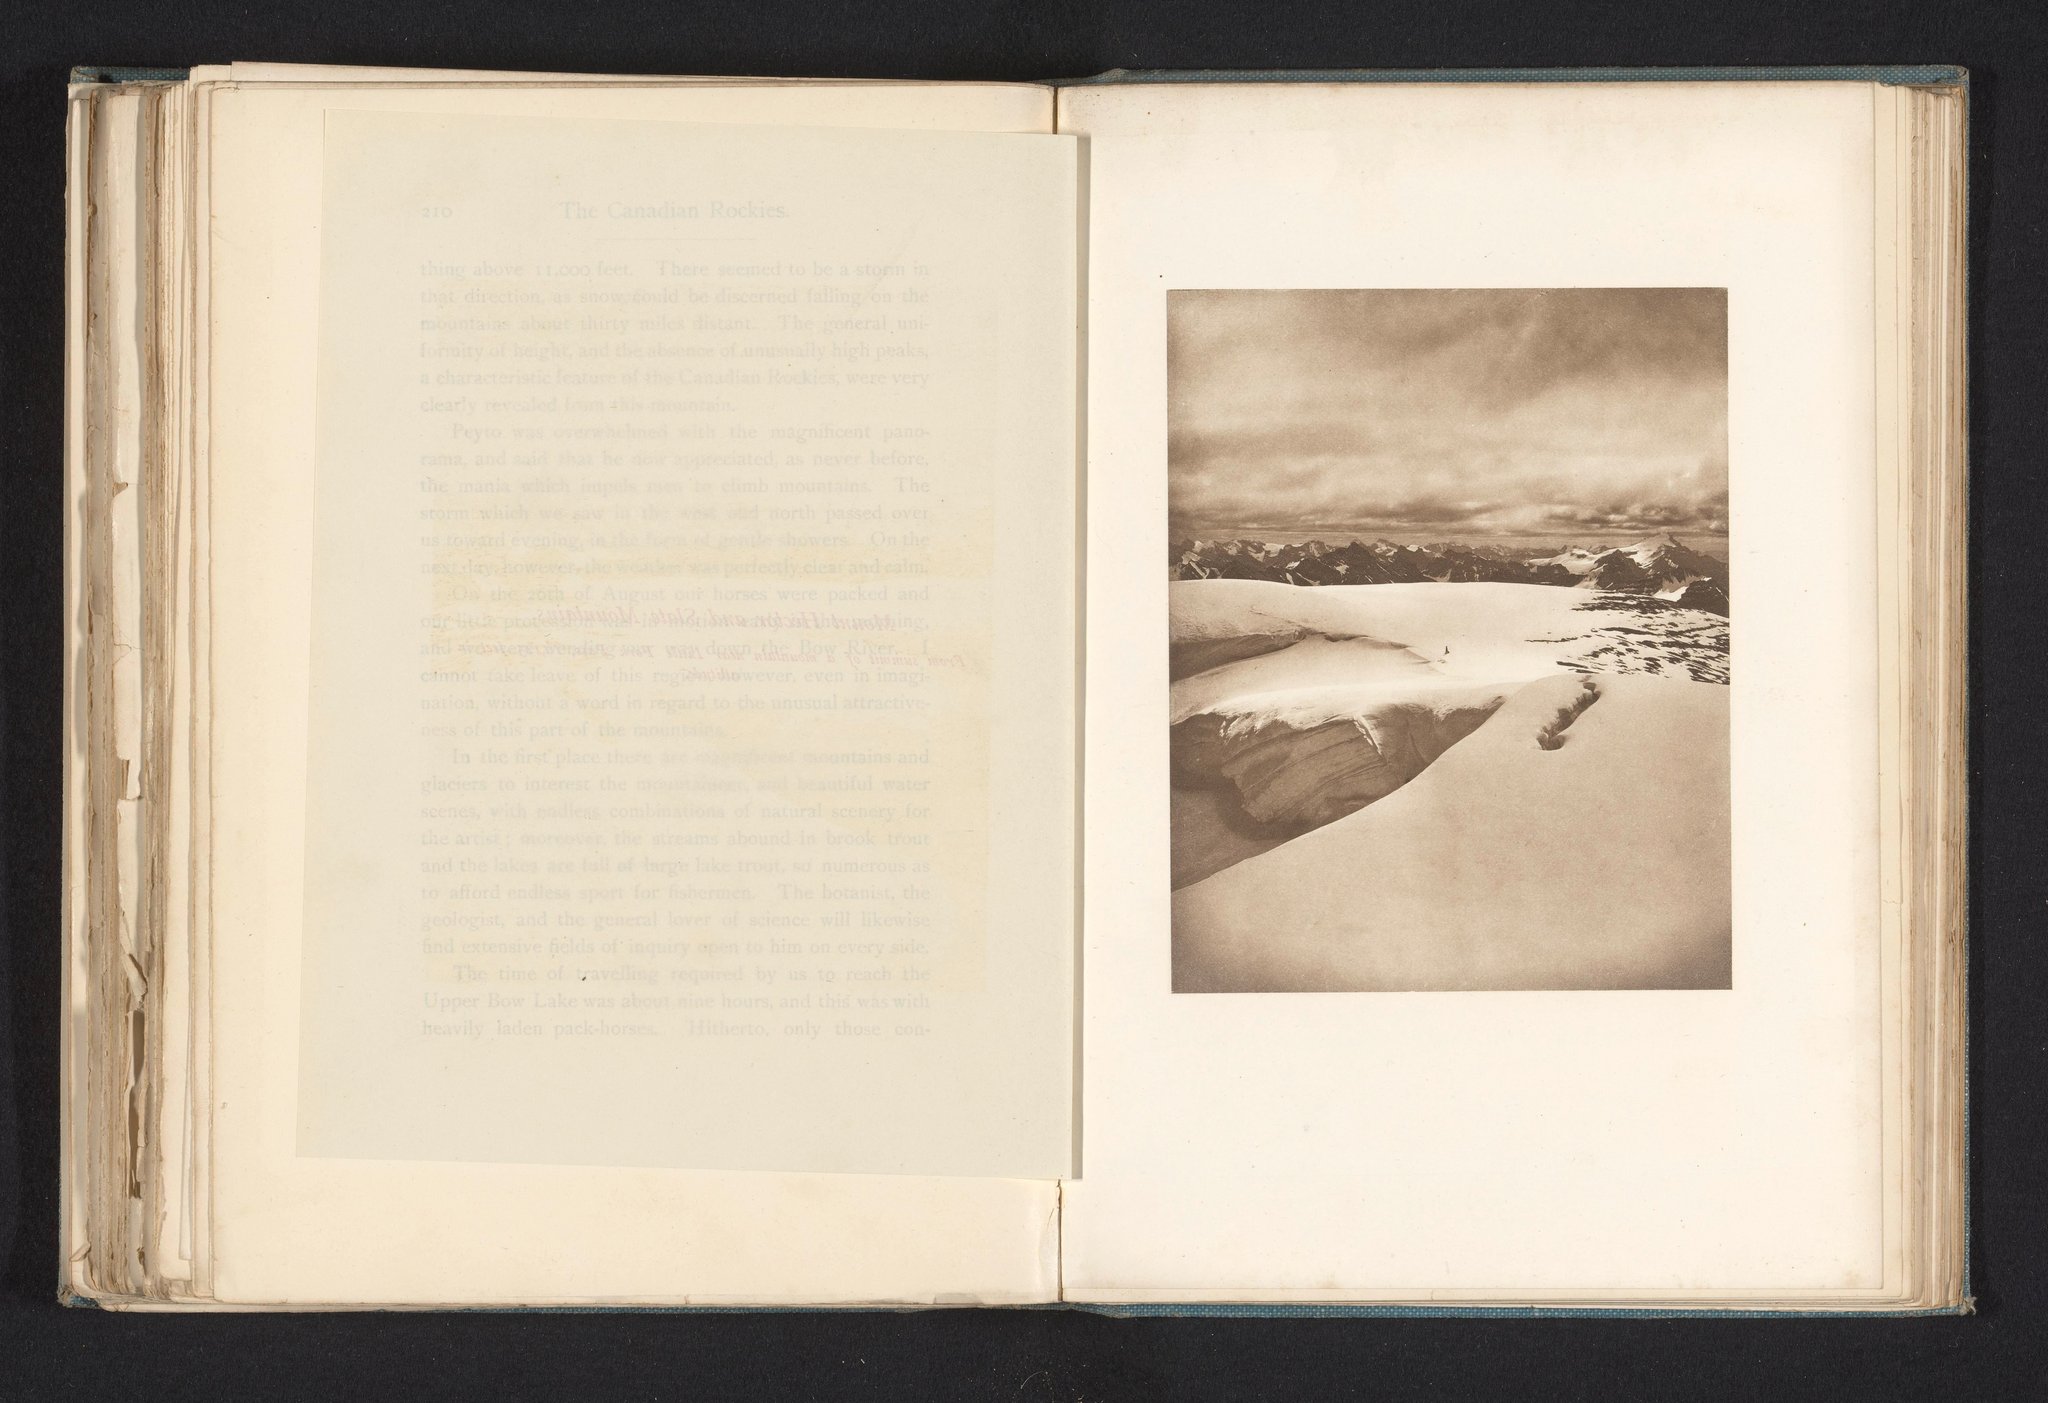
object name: page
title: Gezicht op Mount Hector en de Slate-bergketen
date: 1893-1897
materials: paper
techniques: photoaquatint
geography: alberta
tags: mountain-range, snow peaks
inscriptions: title: ‘Mount Hector and Slate Mountains. From summit of a mountain near Little Fork Pass, 10,125 feet in altitude’